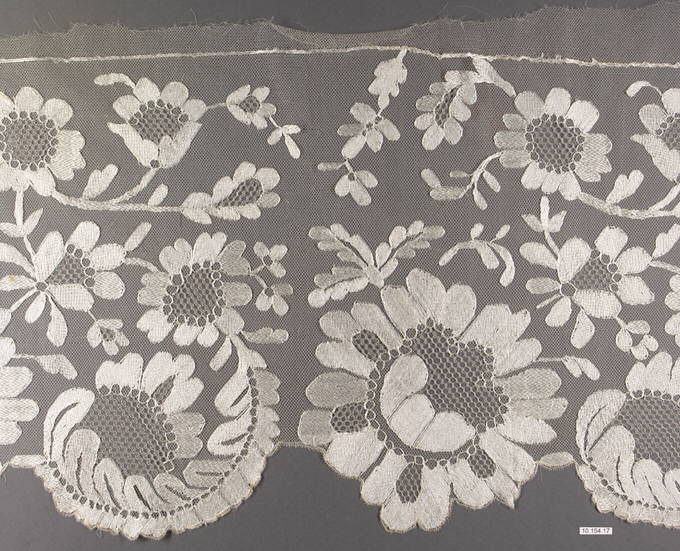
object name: flounce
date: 1801-1900